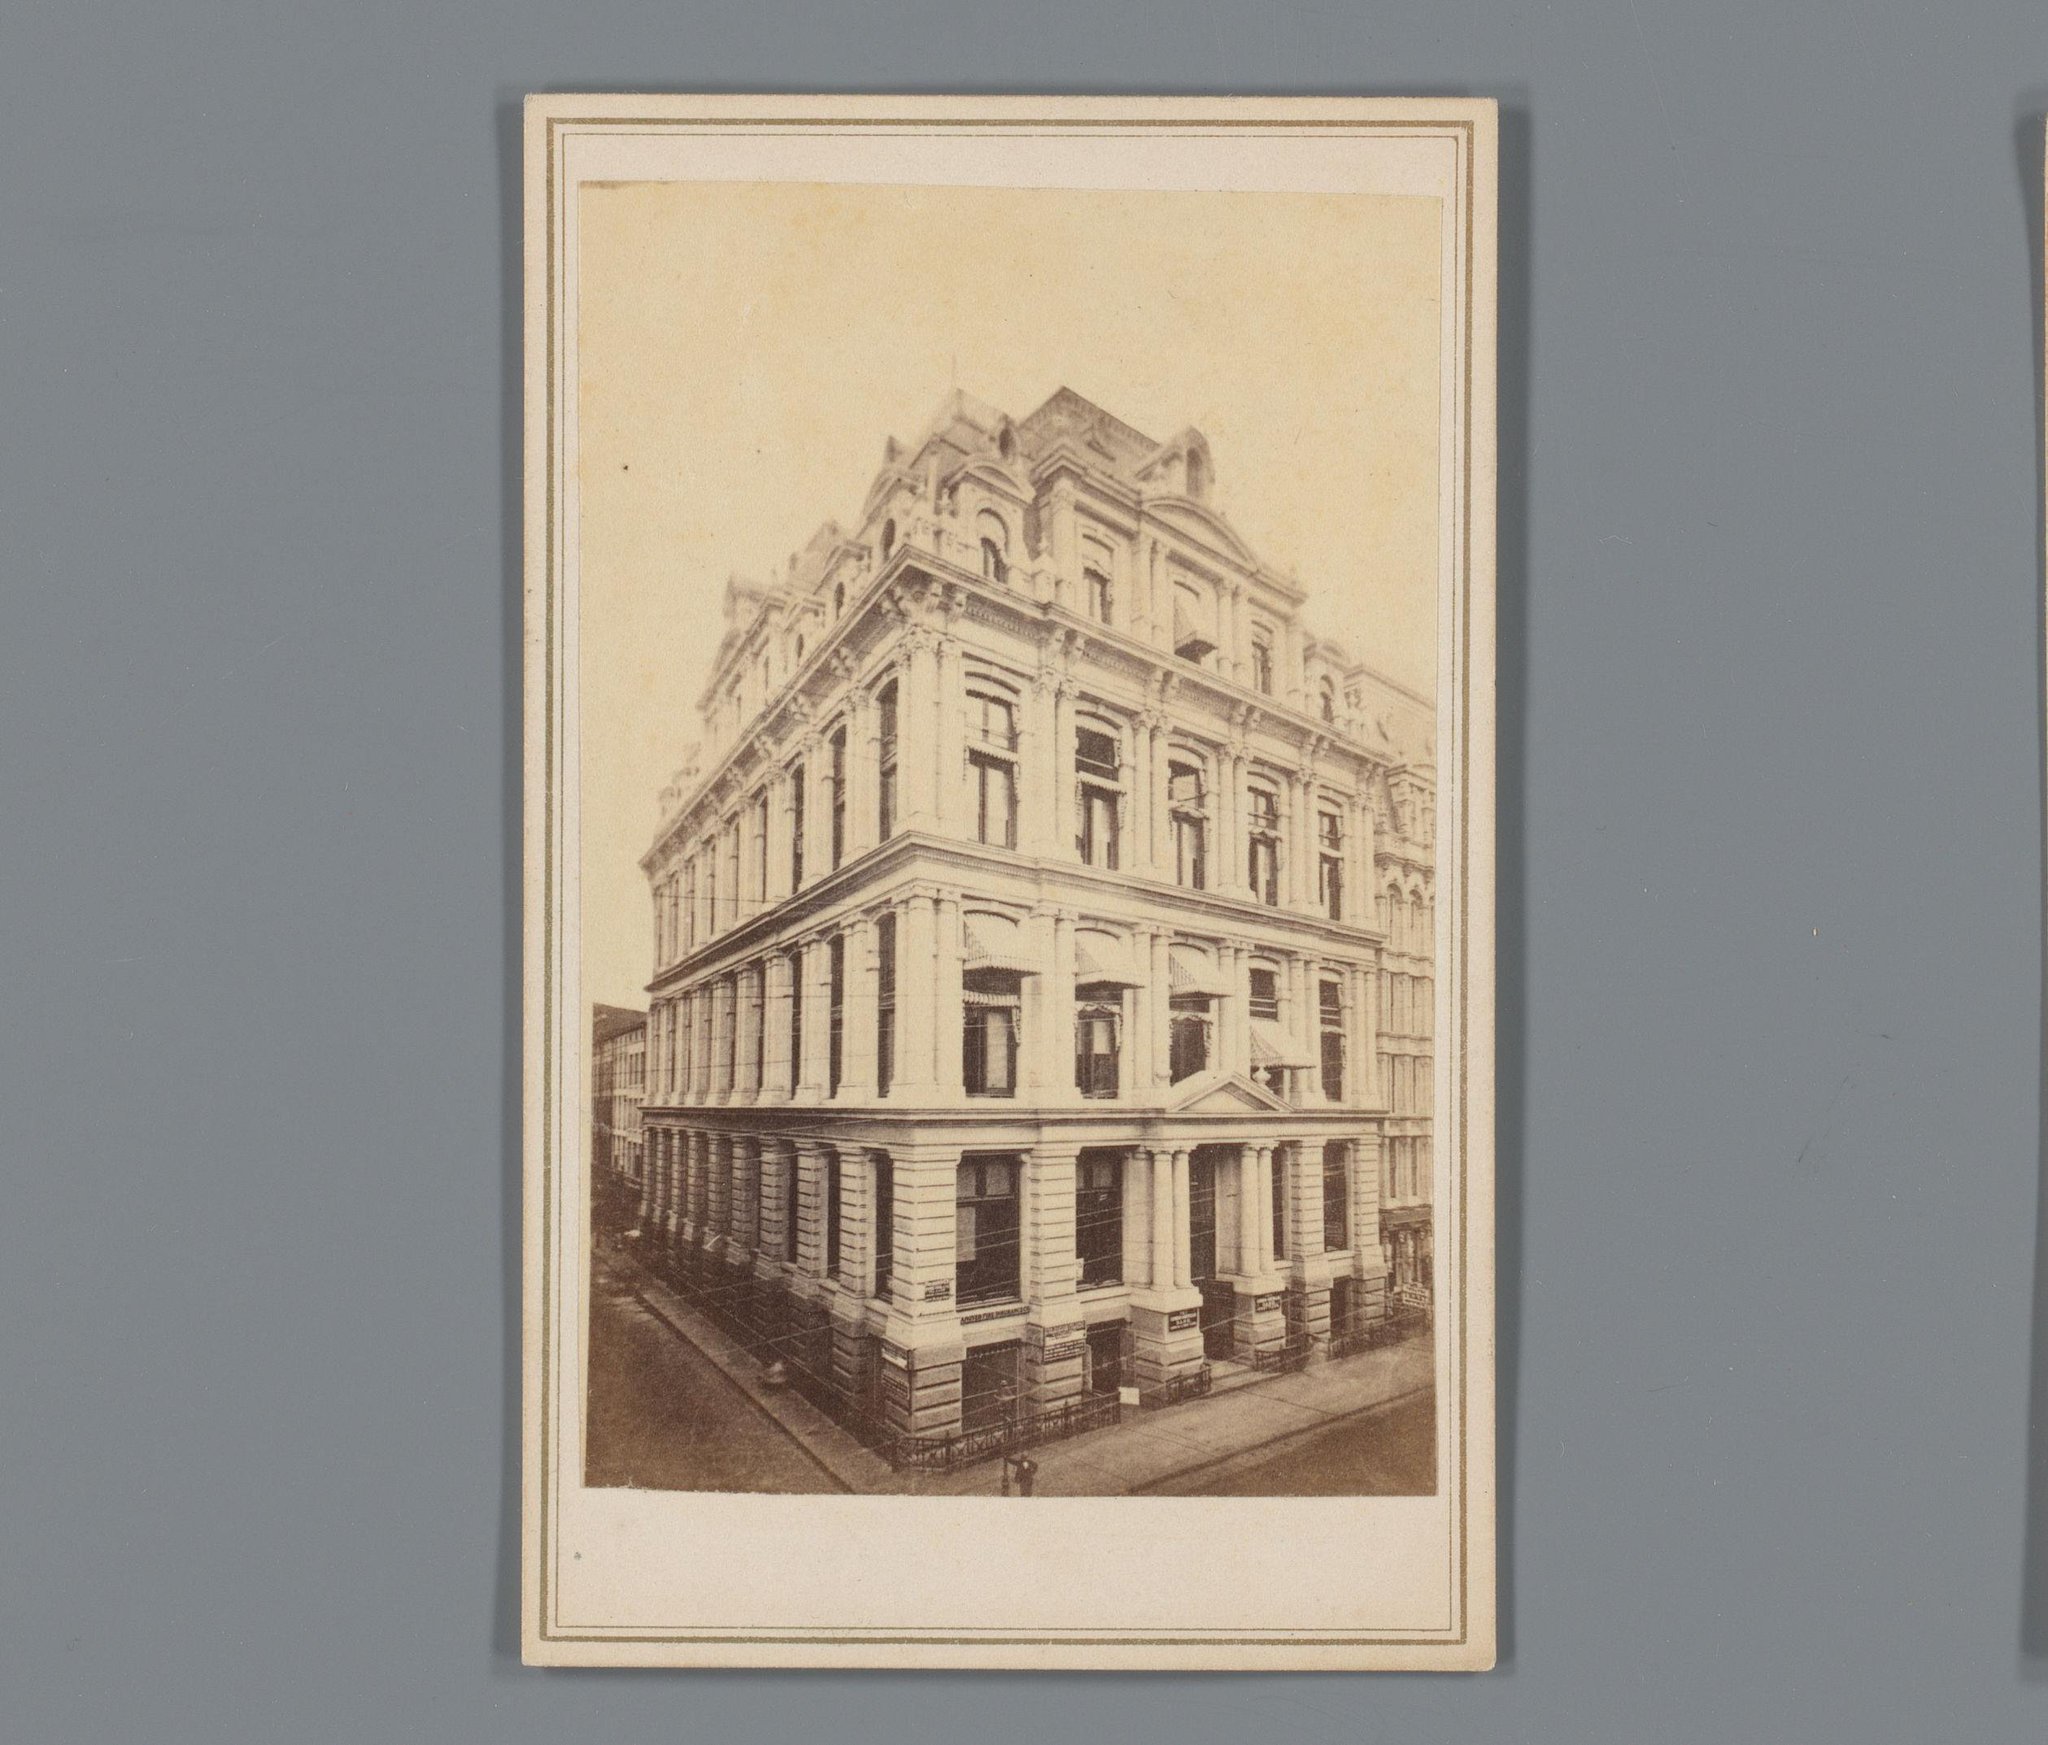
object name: photograph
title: Reclame voor de Life Assurance Society met gezicht op het kantoorpand in New York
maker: Anonymous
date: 1850-1915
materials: cardboard, photographic support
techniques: albumen print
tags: advertising, organization of trade and finance, new york (city)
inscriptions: inscription: ‘(...)’